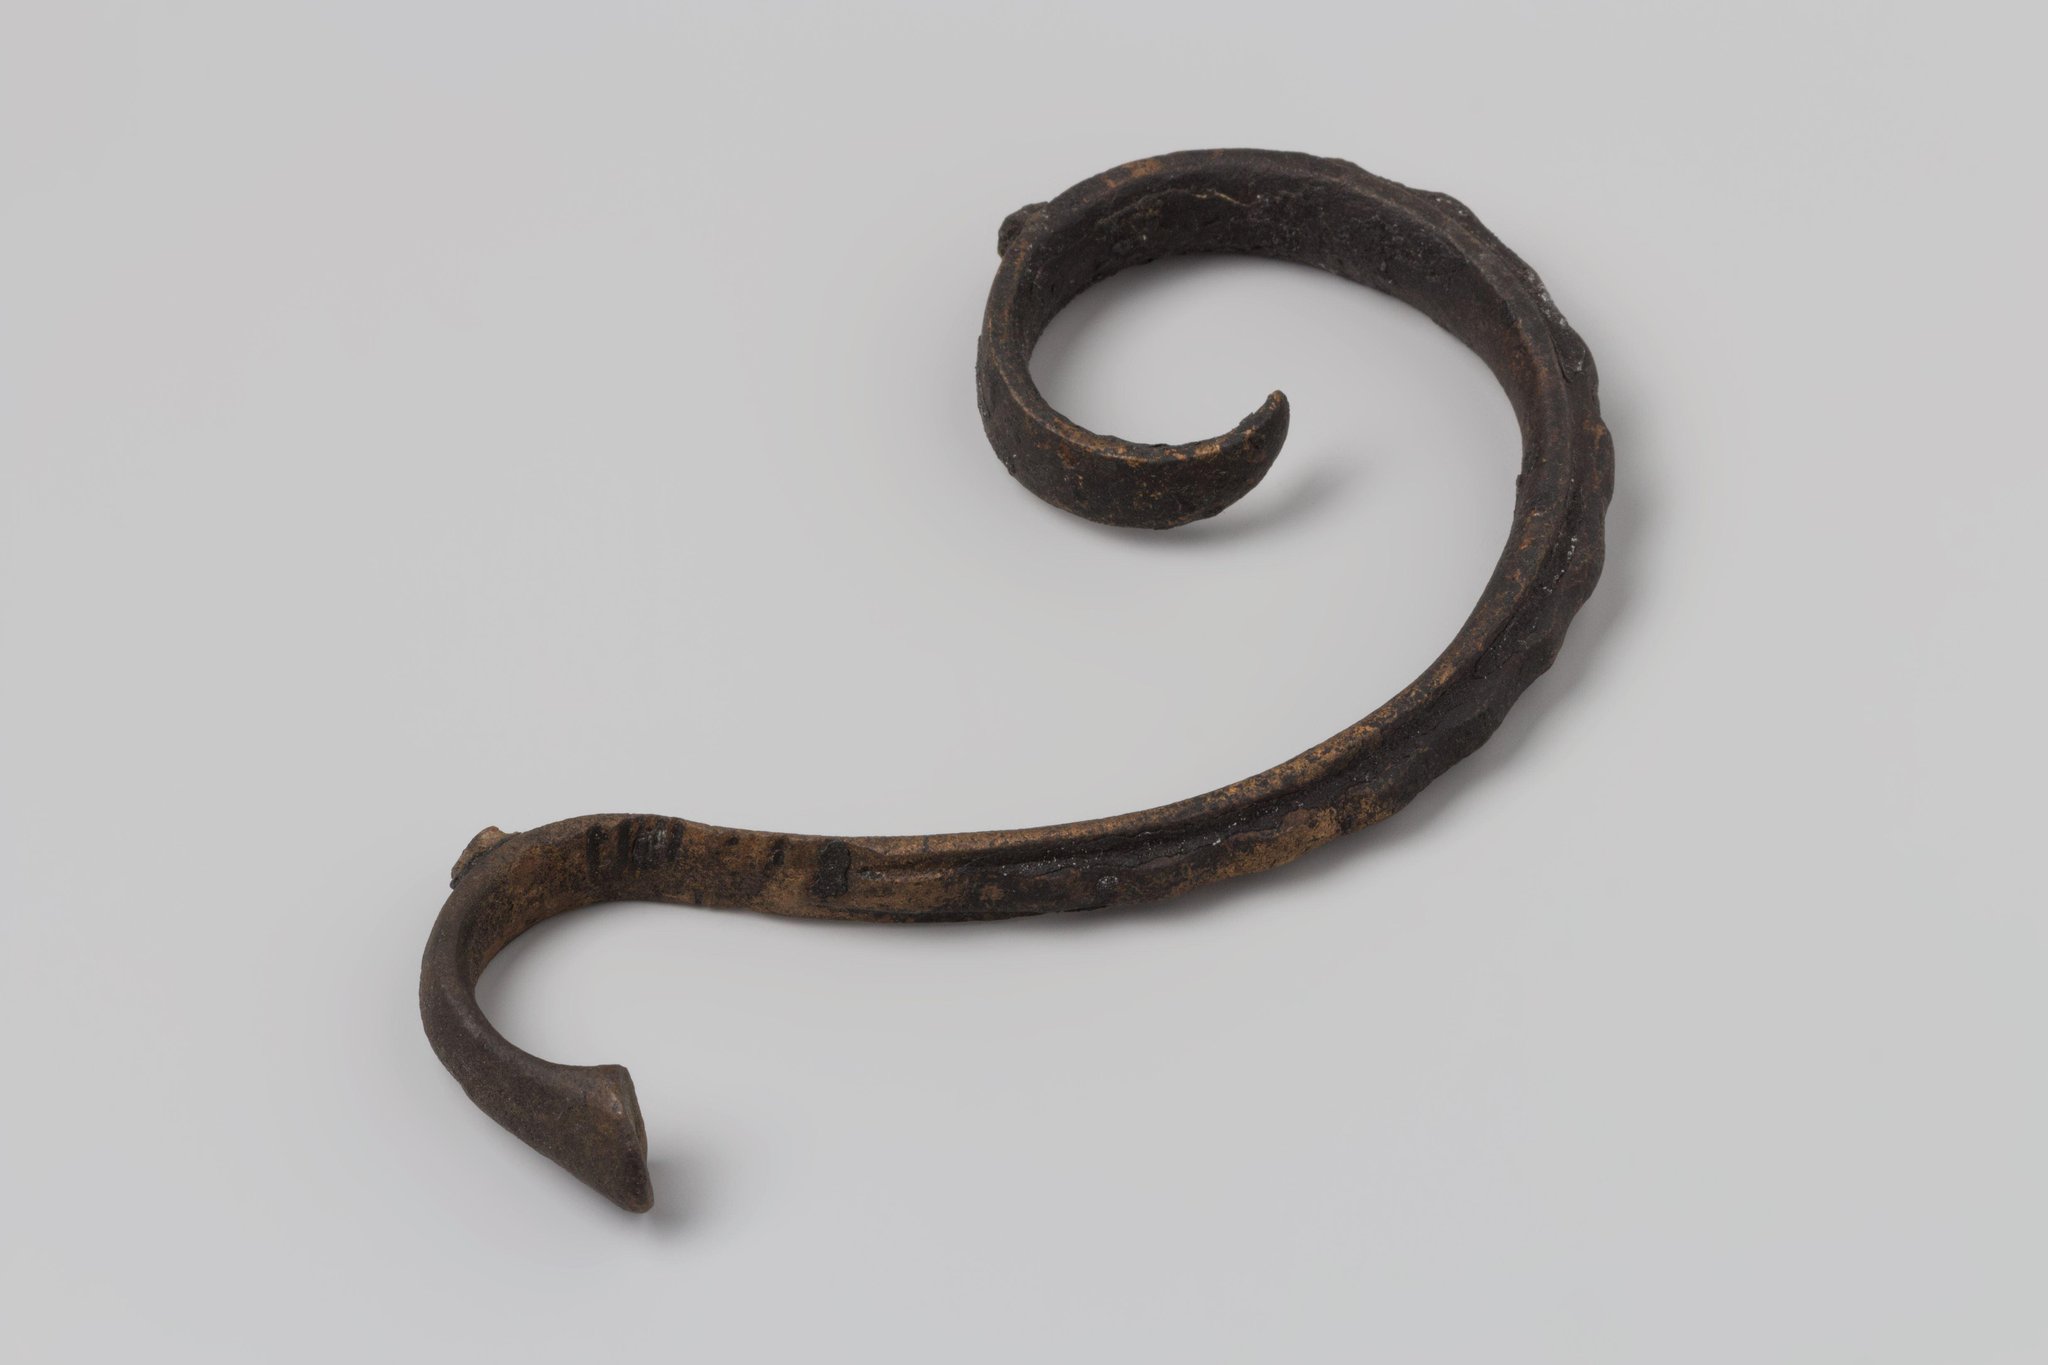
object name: handle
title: Handvat, vermoedelijk van een tinnen kan, uit het wrak van de in 1735 vergane Oost-Indiëvaarder 't Vliegend Hart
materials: copper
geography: middelburg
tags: 't vliegend hart (schip), verenigde oostindische compagnie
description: Handvat in de vorm van een zeepaardje 'en profile' van zwartgeworden tin. Op de rug van het handvat zitten ribbels. Het handvat zat op twee punten bevestigd aan het oorspronkelijke stuk vaatwerk.